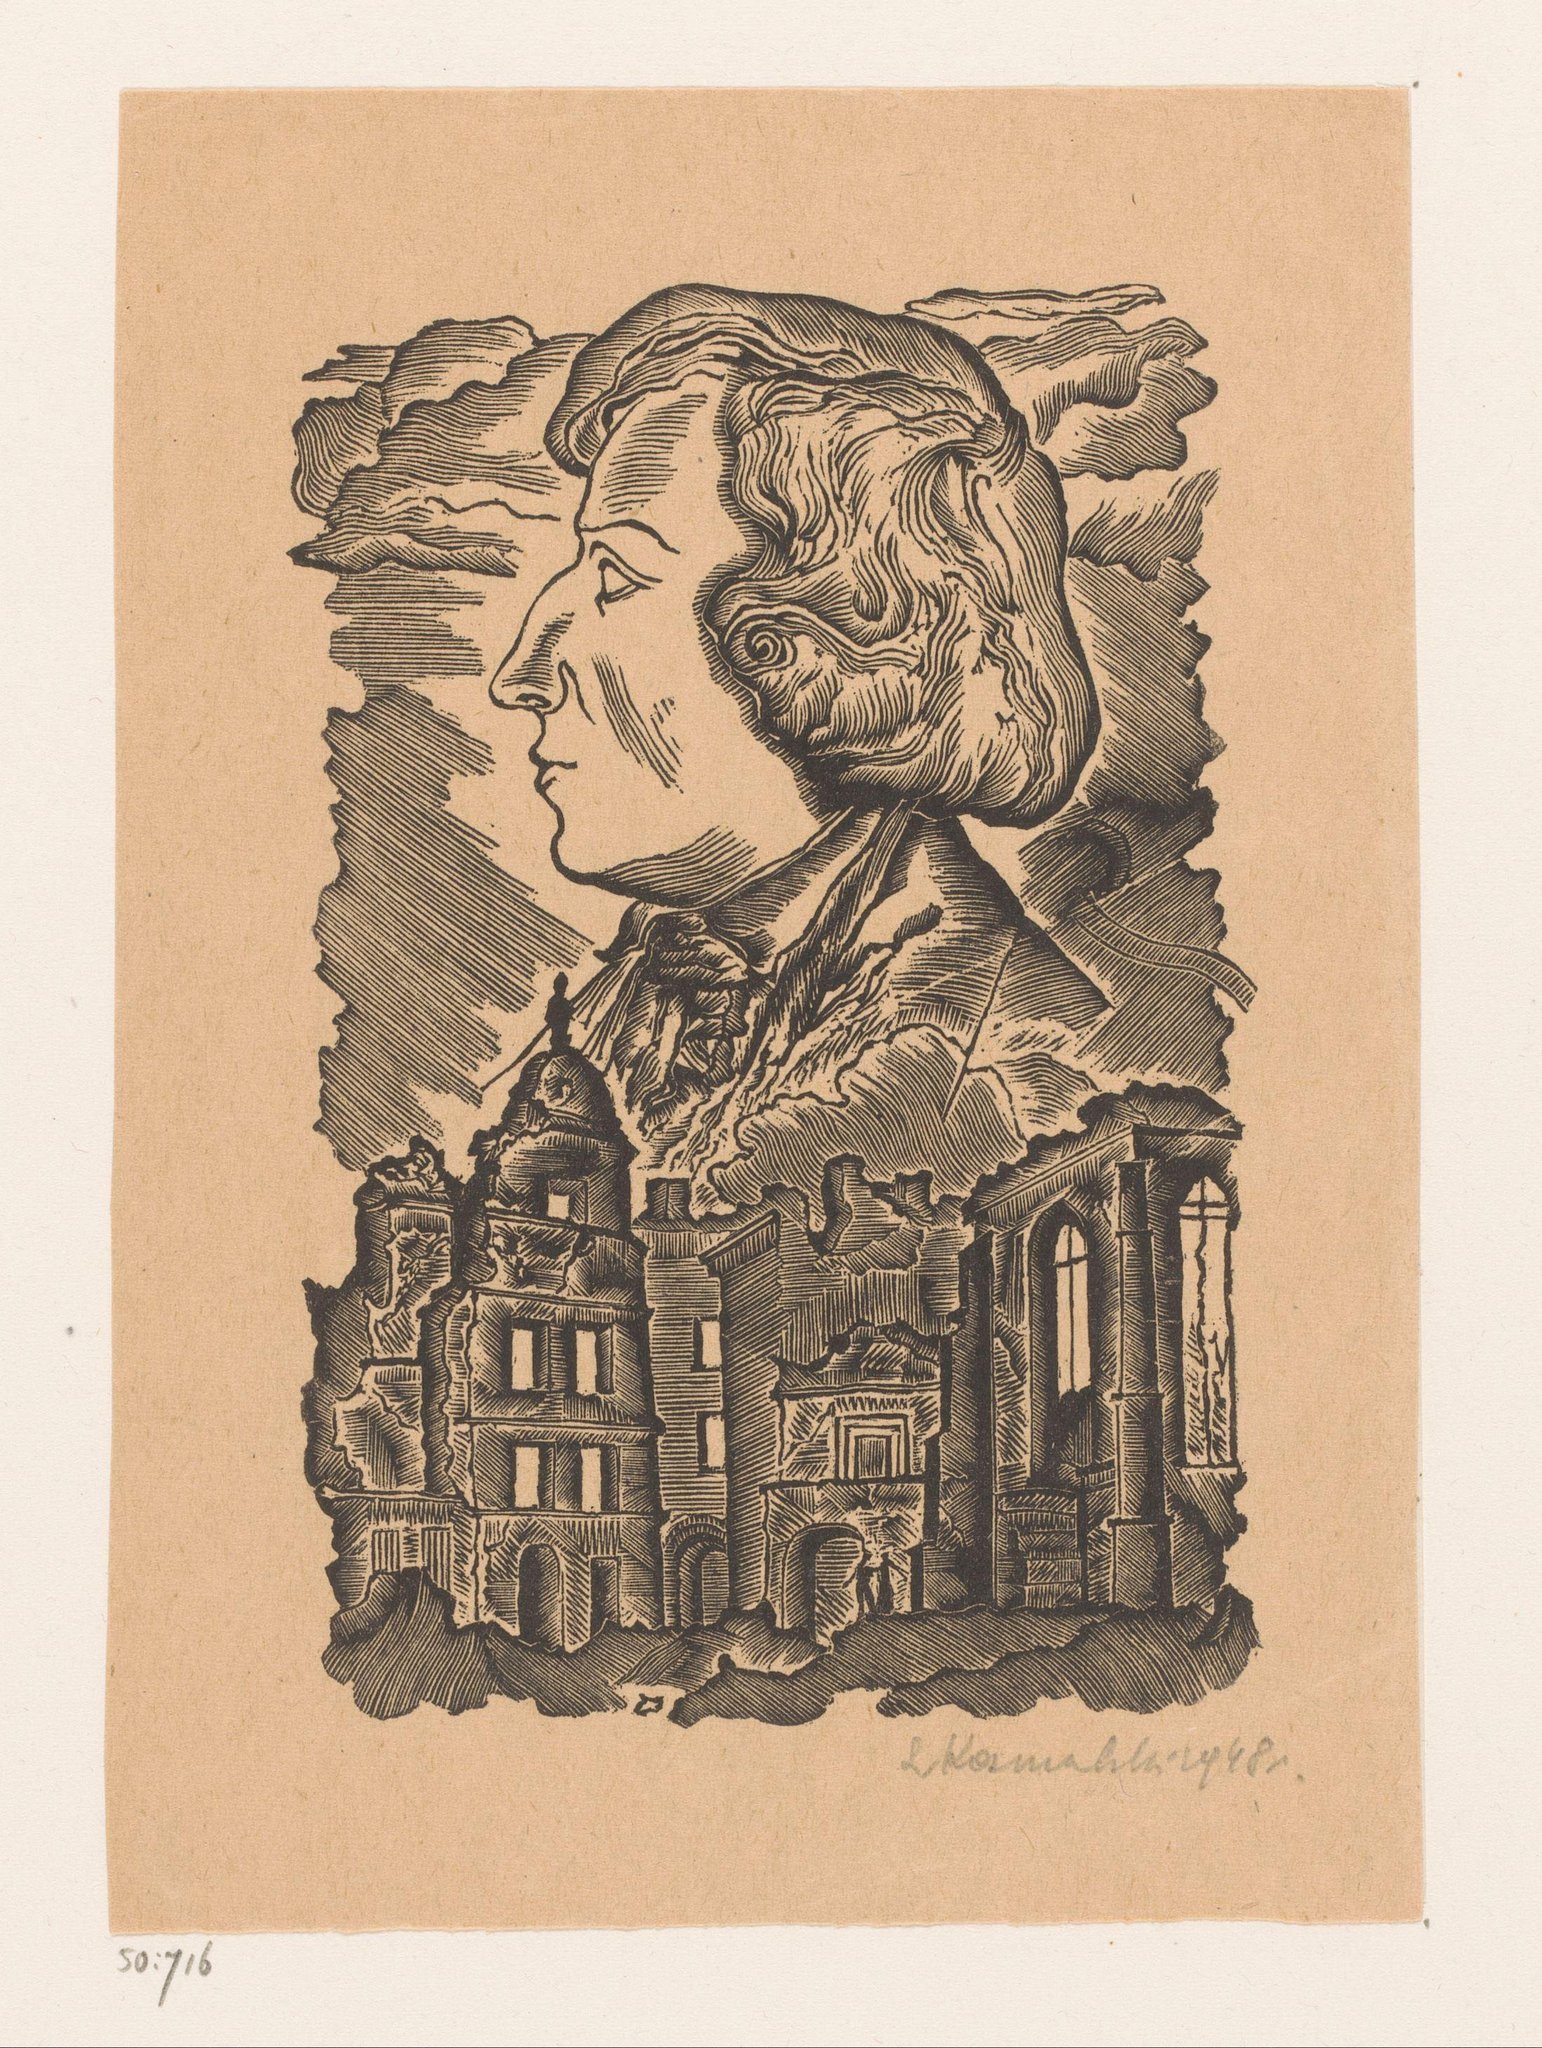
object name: print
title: Portret van Frédéric Chopin boven een verwoeste stad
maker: leon kosmulski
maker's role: print maker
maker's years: 1904-1952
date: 1948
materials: paper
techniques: woodcut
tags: city-view in general; 'veduta', portrait of a musician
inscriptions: collector's mark: Lugt 2228